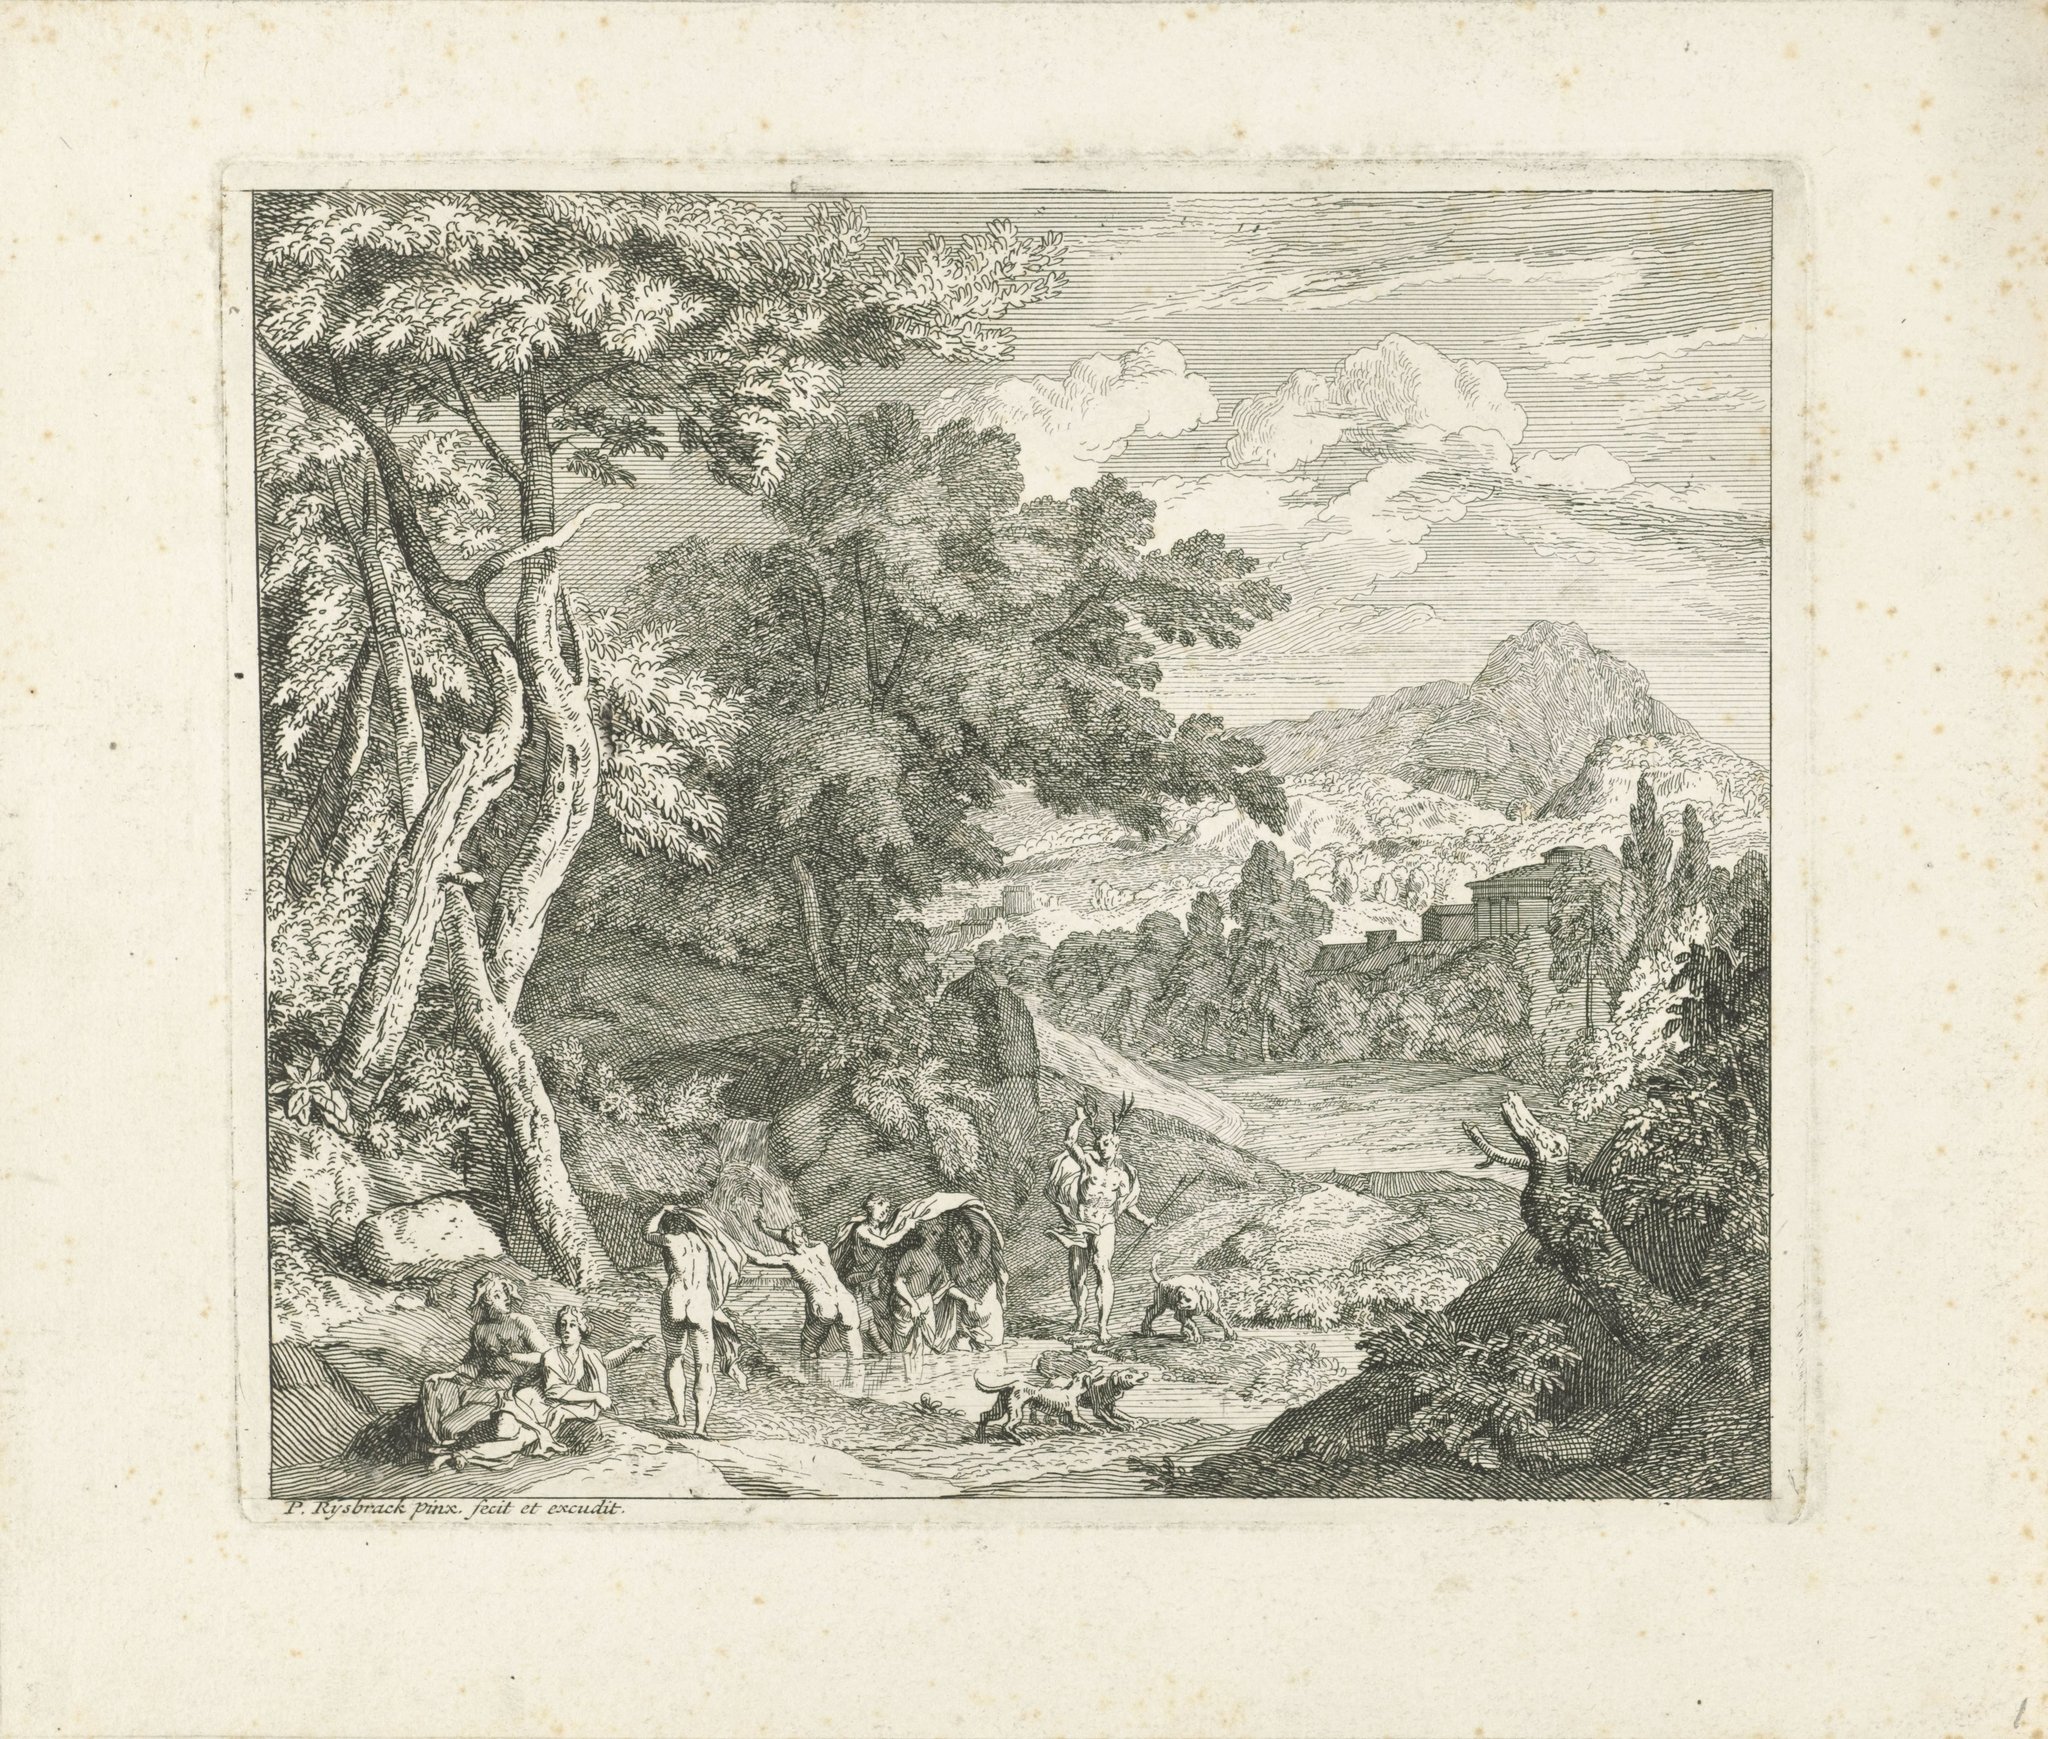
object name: print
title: Landschappen met figuren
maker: pieter rijsbraeck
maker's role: print maker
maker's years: 1655-1729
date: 1670-1729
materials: paper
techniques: etching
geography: southern netherlands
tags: actaeon changed into a stag: as punishment for seeing her bathe, diana changes actaeon, the hunter, into a stag (ovid, metamorphoses iii 193)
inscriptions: collector's mark: Lugt 240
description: Gezicht op een heuvelachtig landschap waar Diana en haar nimfen een bad nemen in een rivier. Bij de rivier staat de jonge jager Actaeon met zijn honden. De nimfen probeerden Diana zo goed mogelijk tegen de blikken van Actaeon te beschermen. Omdat Actaeon Diana toch naakt zag, veranderde zij hem als straf onmiddellijk in een hert.